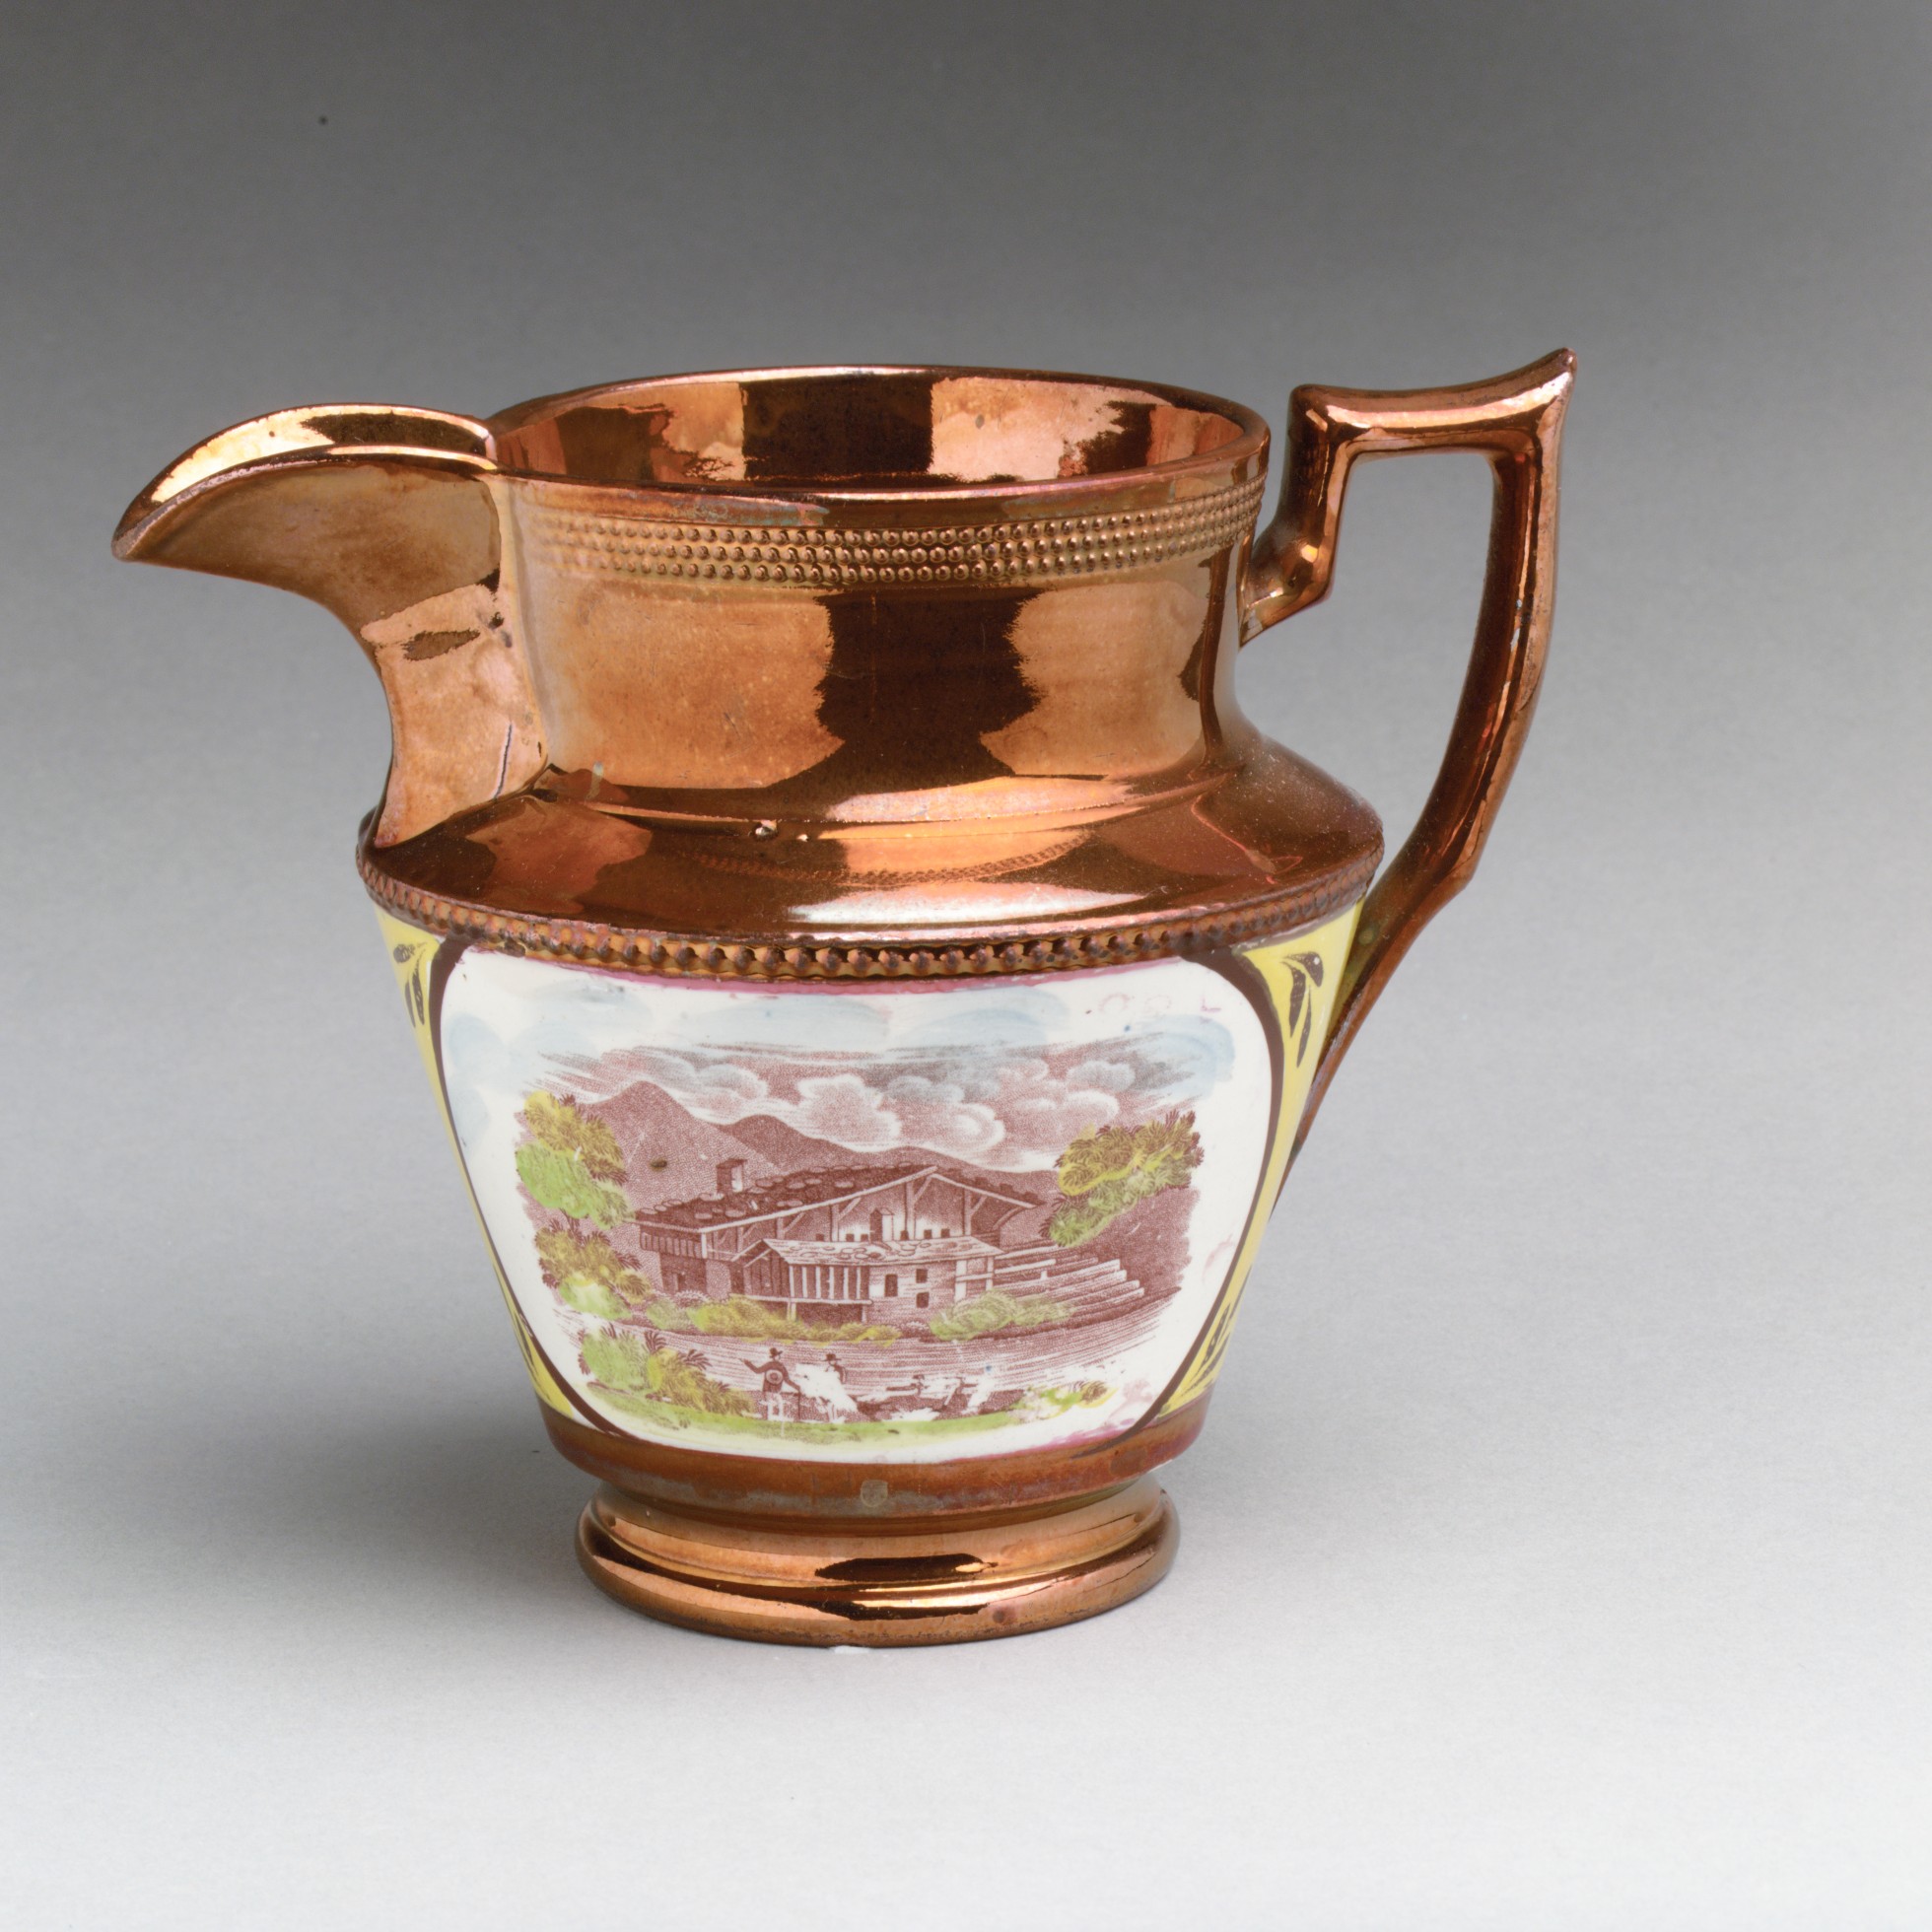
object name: pitcher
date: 1801-1900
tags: houses